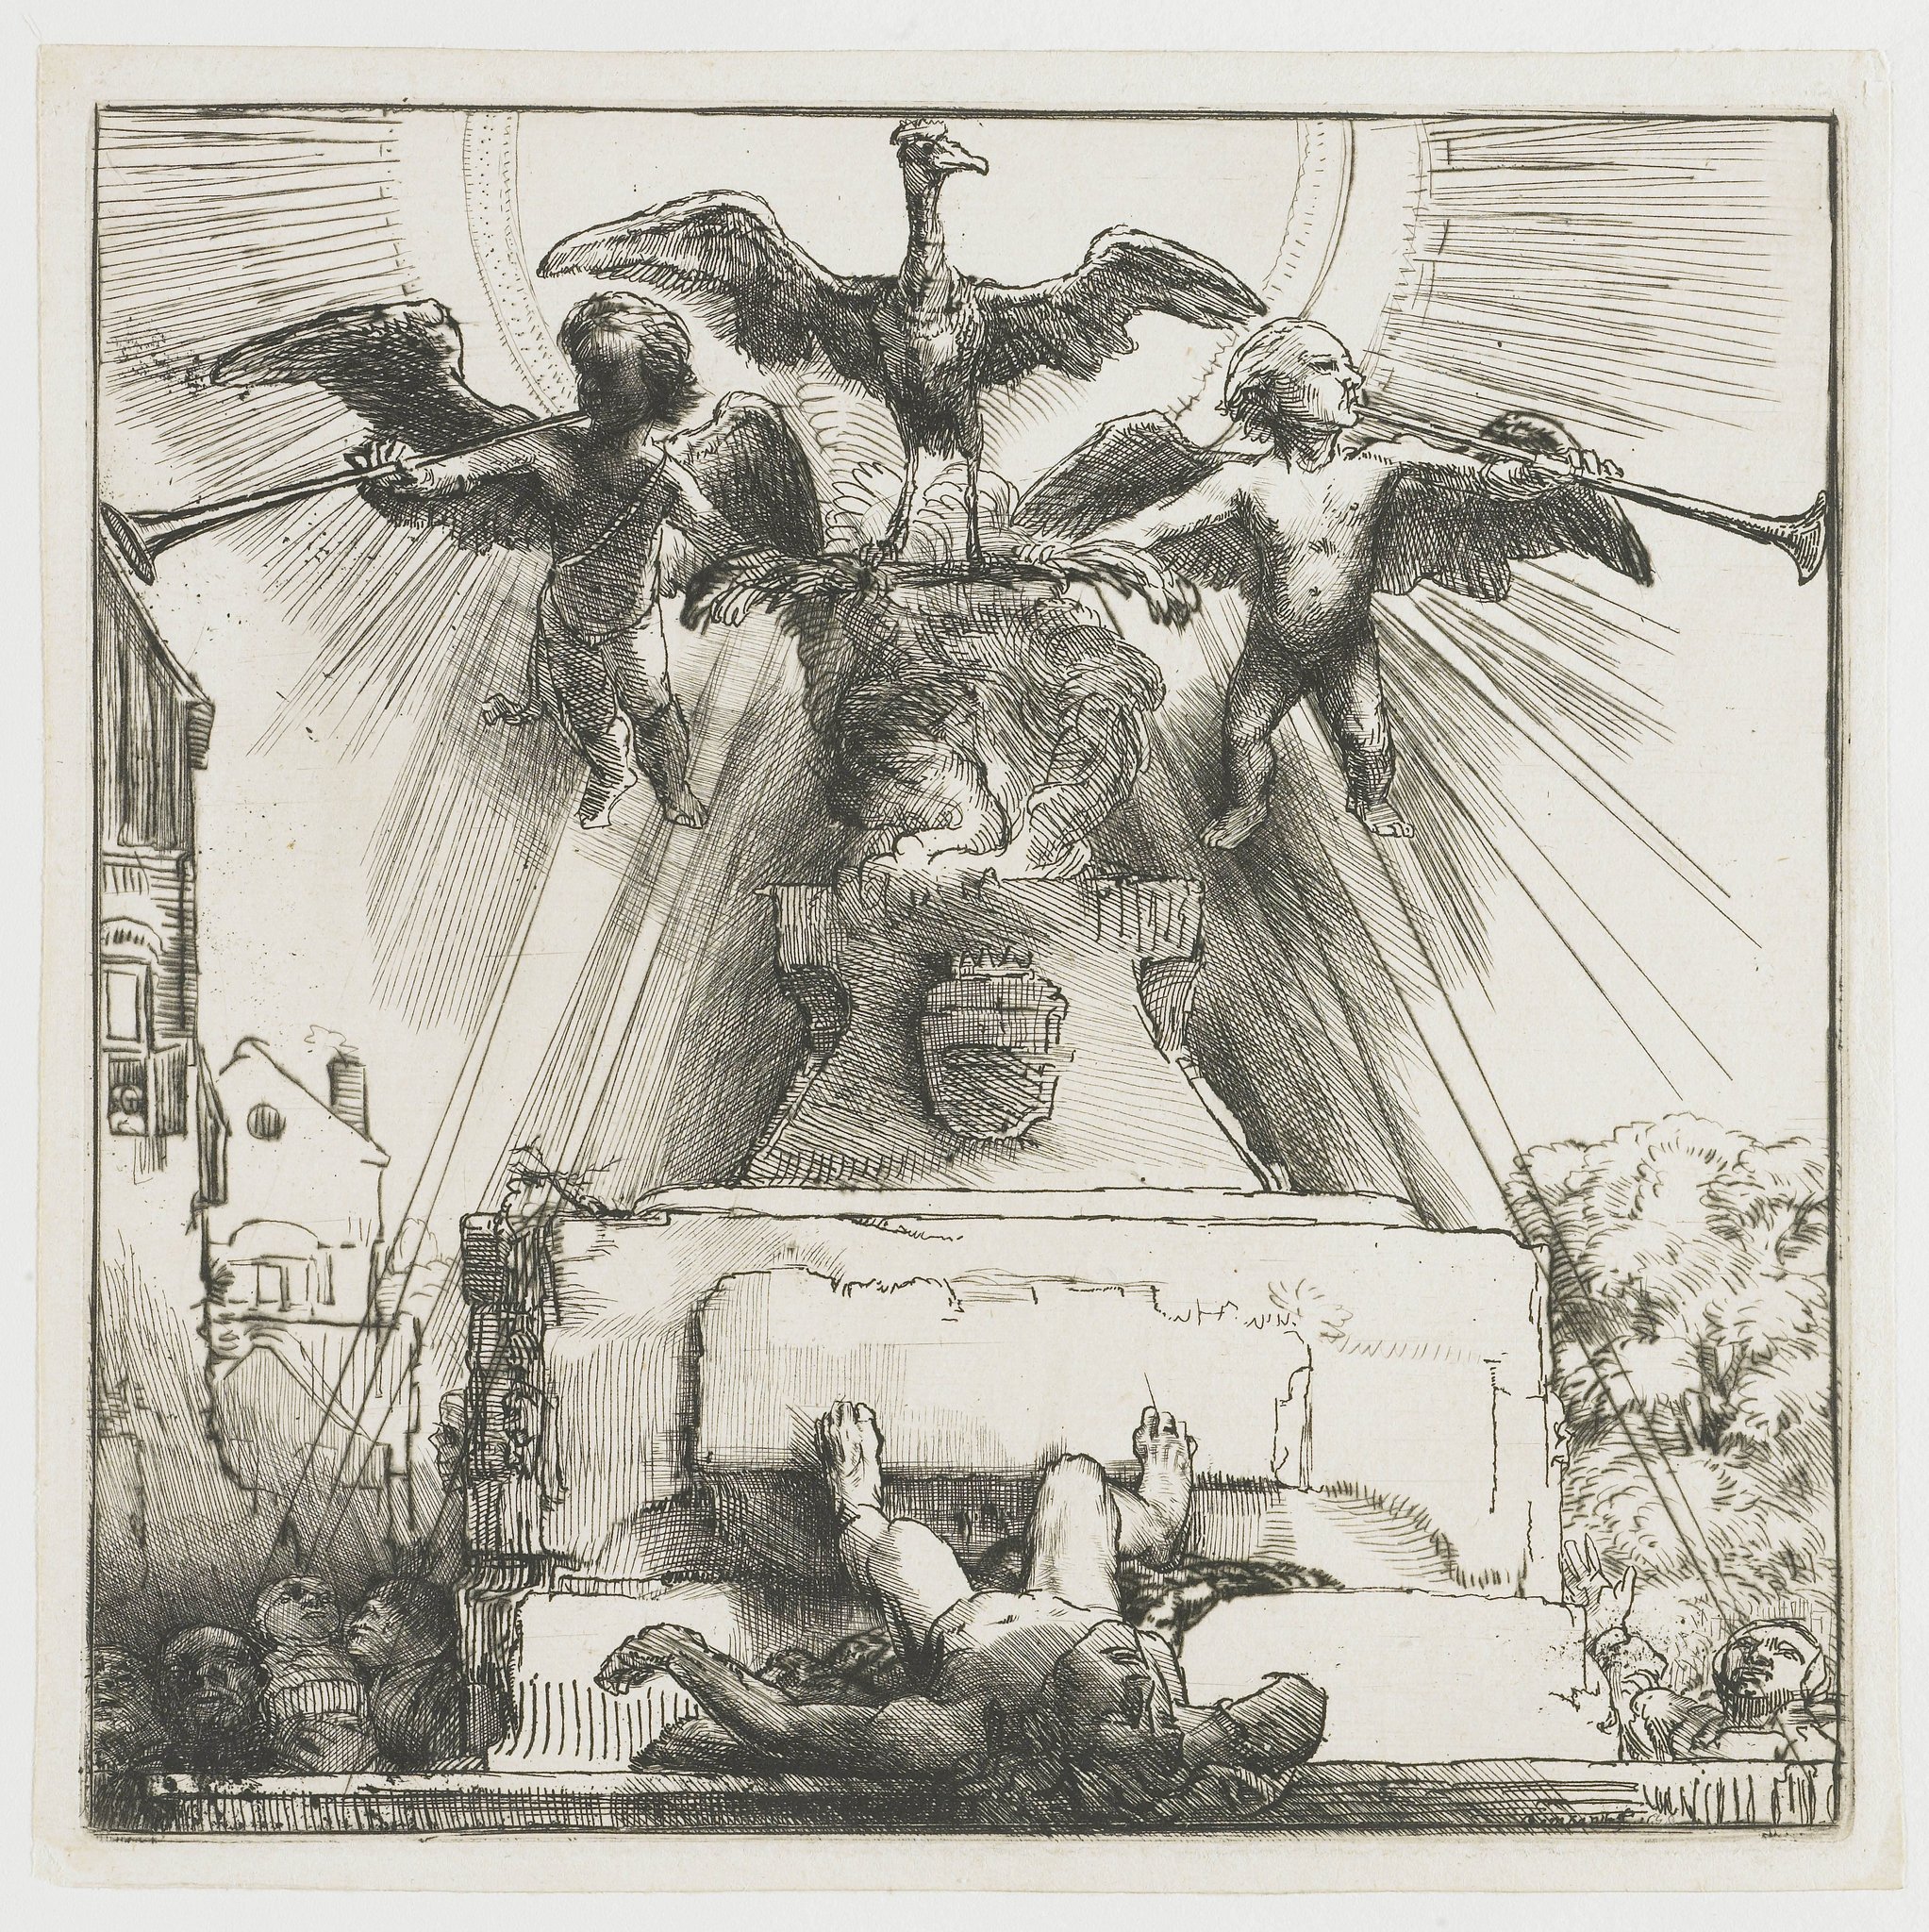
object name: print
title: The phoenix or the statue overthrown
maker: rembrandt van rijn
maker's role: draughtsman, painter, print maker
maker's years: 1606-1669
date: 1658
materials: paper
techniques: drypoint, etching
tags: symbols of christ ~ animals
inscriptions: collector's mark: Lugt 240